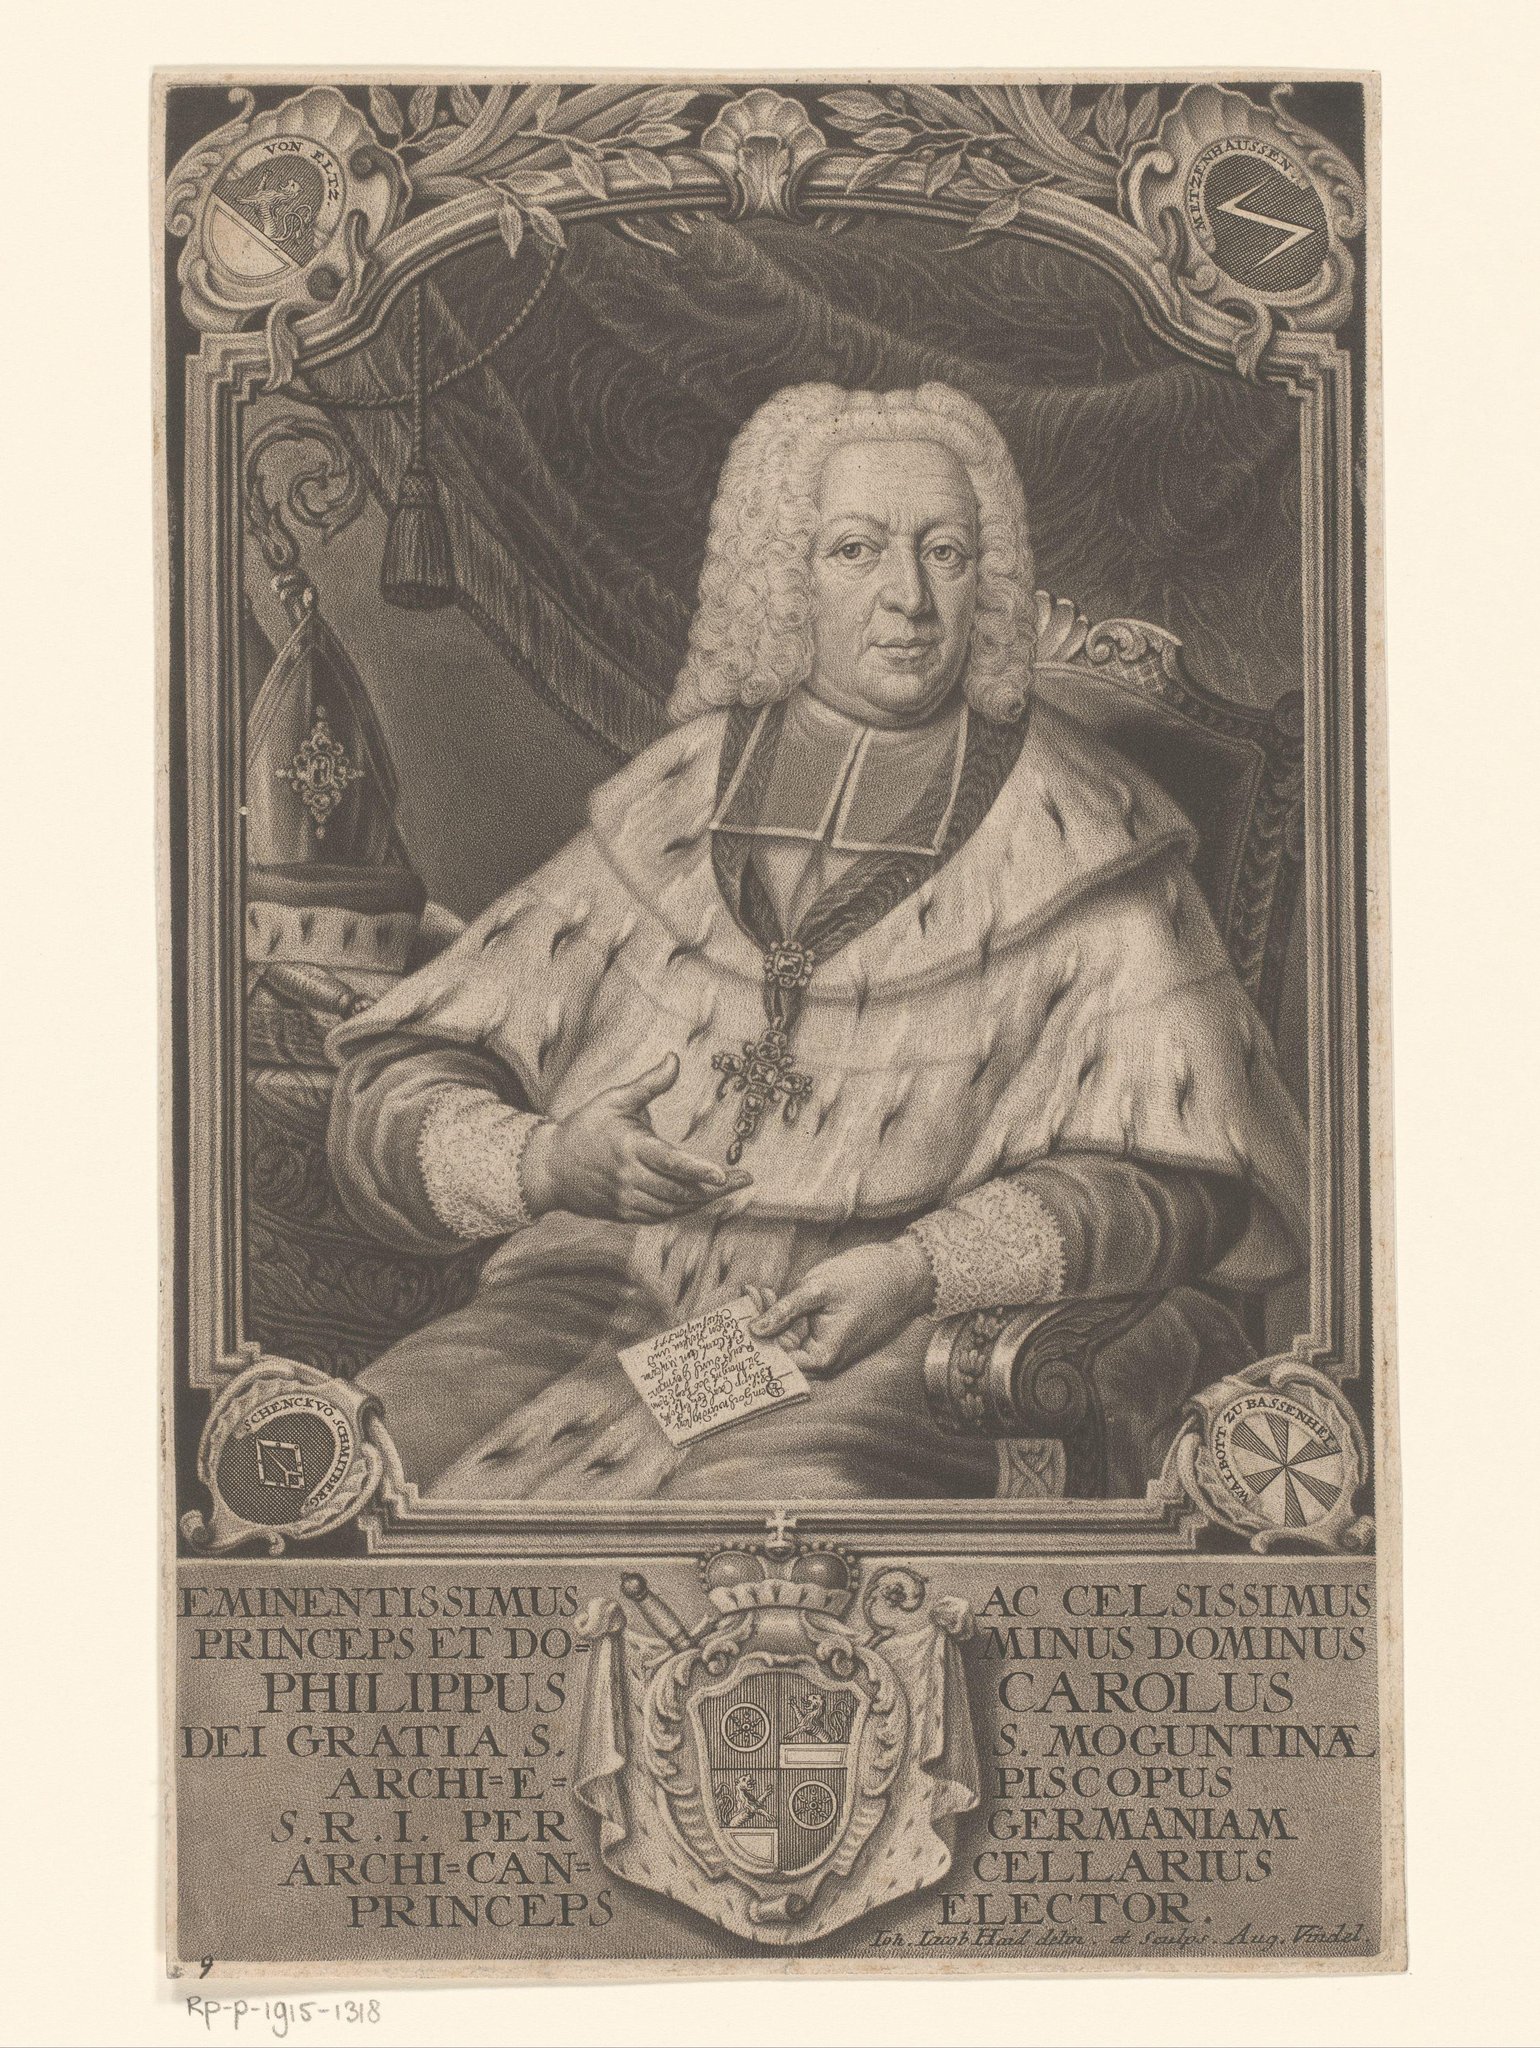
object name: print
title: Portret van Philipp Karl von Eltz-Kempenich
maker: johann jacob haid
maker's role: print maker, publisher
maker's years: 1704-1767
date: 1714-1743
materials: paper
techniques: etching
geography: augsburg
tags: trees: laurel (branch, stick), trees: palm-tree (+ branch, stick), archbishop, bishop, etc. (roman catholic), insignia of bishop, e.g. mitre, crozier, historical persons, pendant, trinket, 'breloque', armorial bearing, heraldry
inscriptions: collector's mark: Lugt 2228